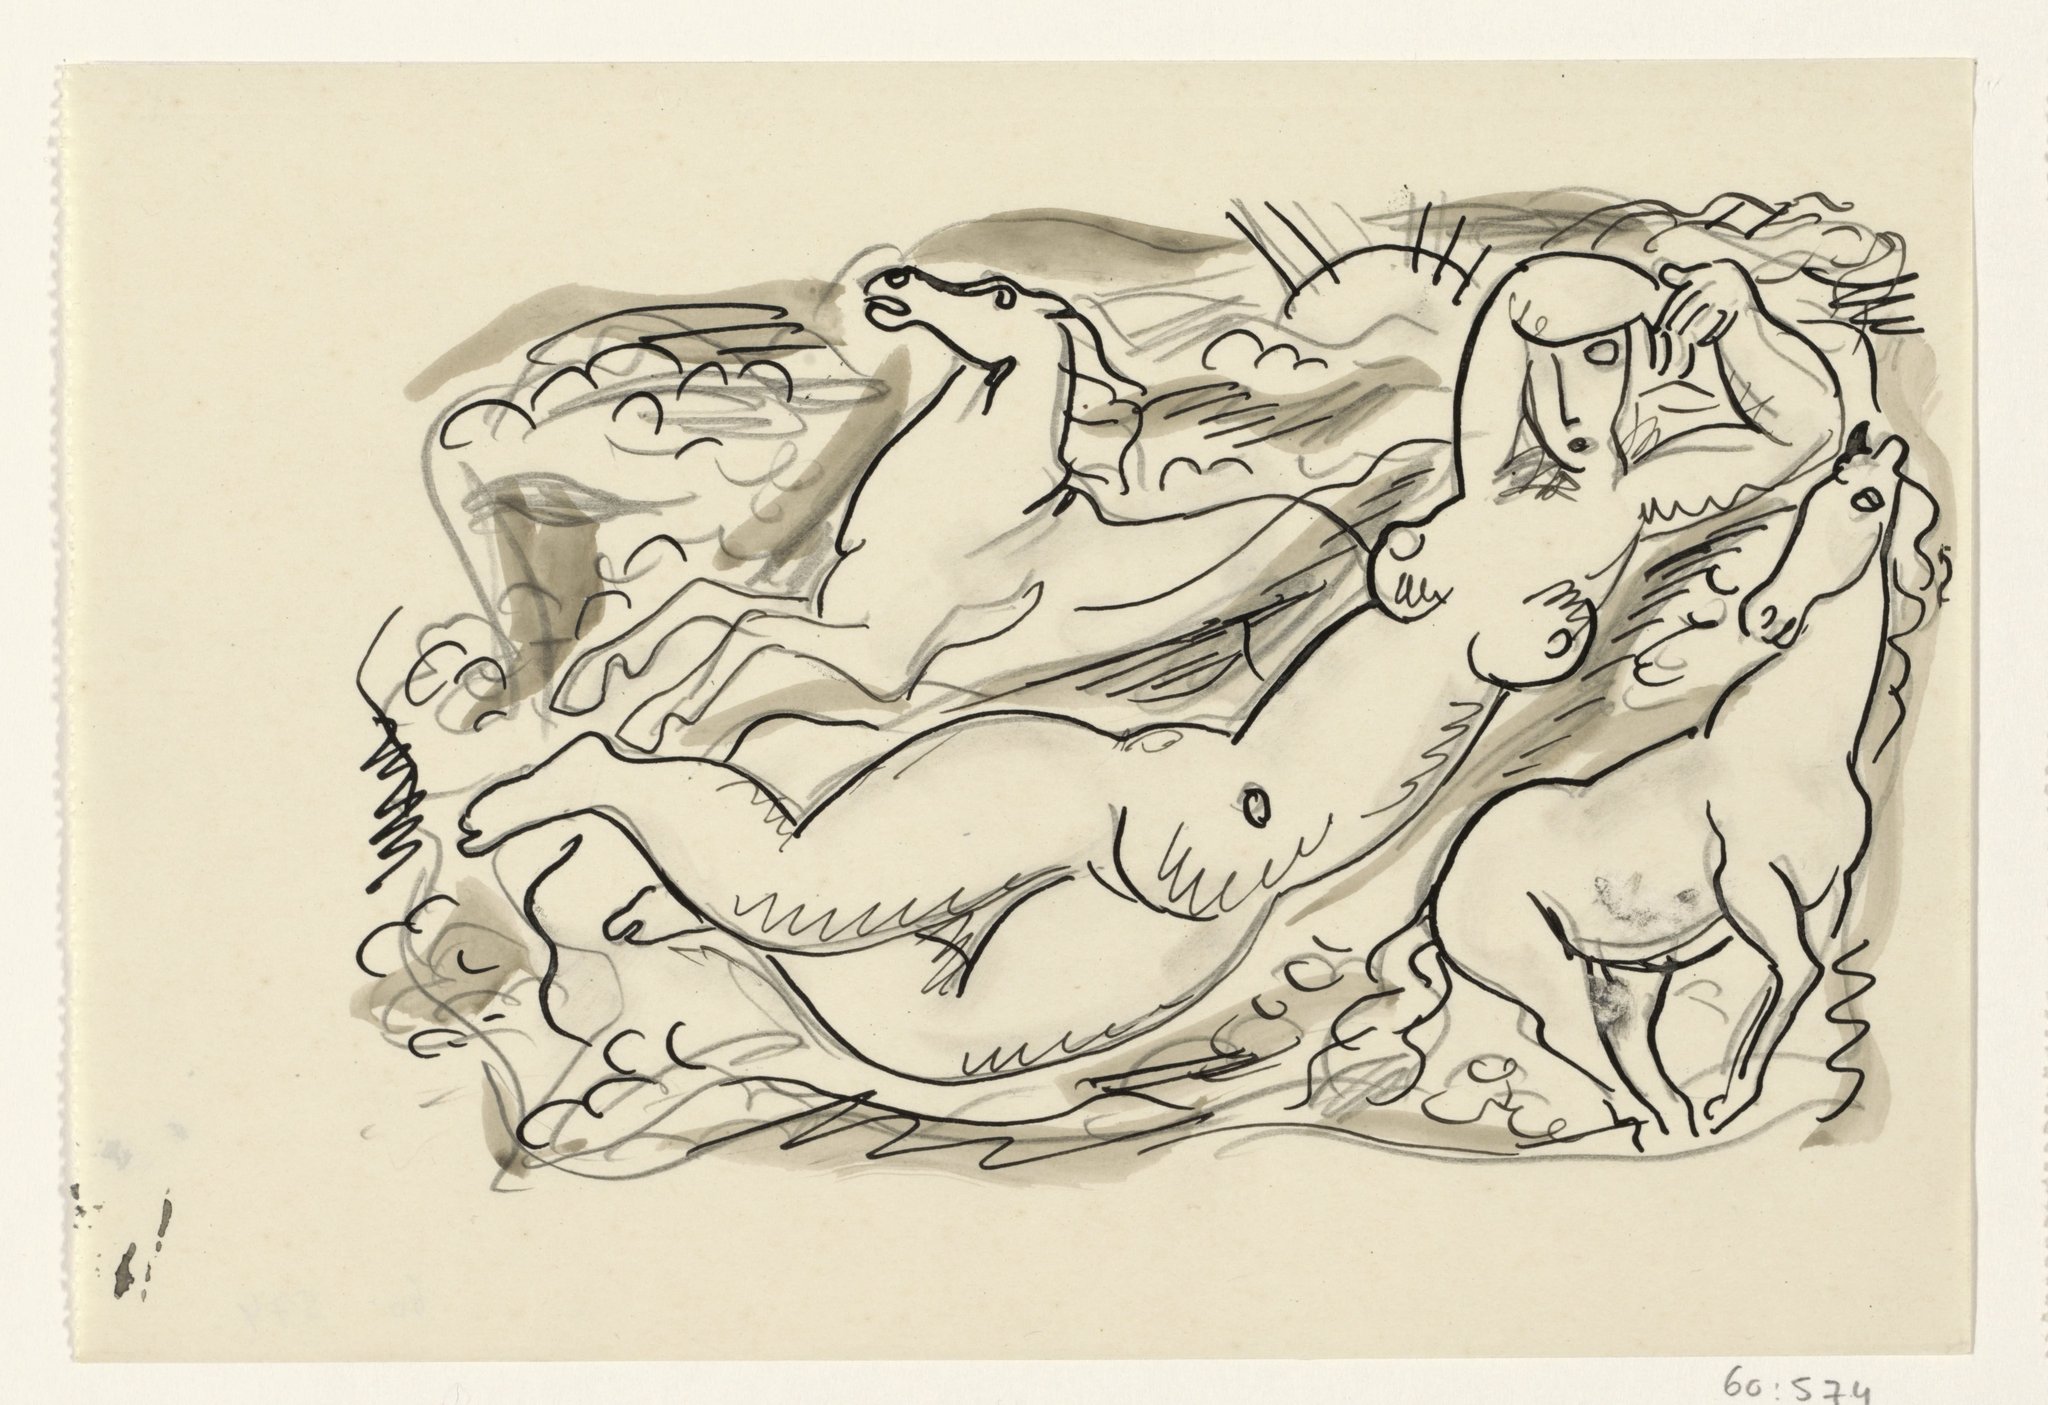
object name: design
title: Naakte vrouw en twee paarden in zee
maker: leo gestel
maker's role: draughtsman, print maker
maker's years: 1881-1941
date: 1891-1941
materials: ink, paper, pencil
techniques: brush, pen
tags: female sex; woman (+ nude human being), sea (seascape), horse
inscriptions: collector's mark: Lugt 2228